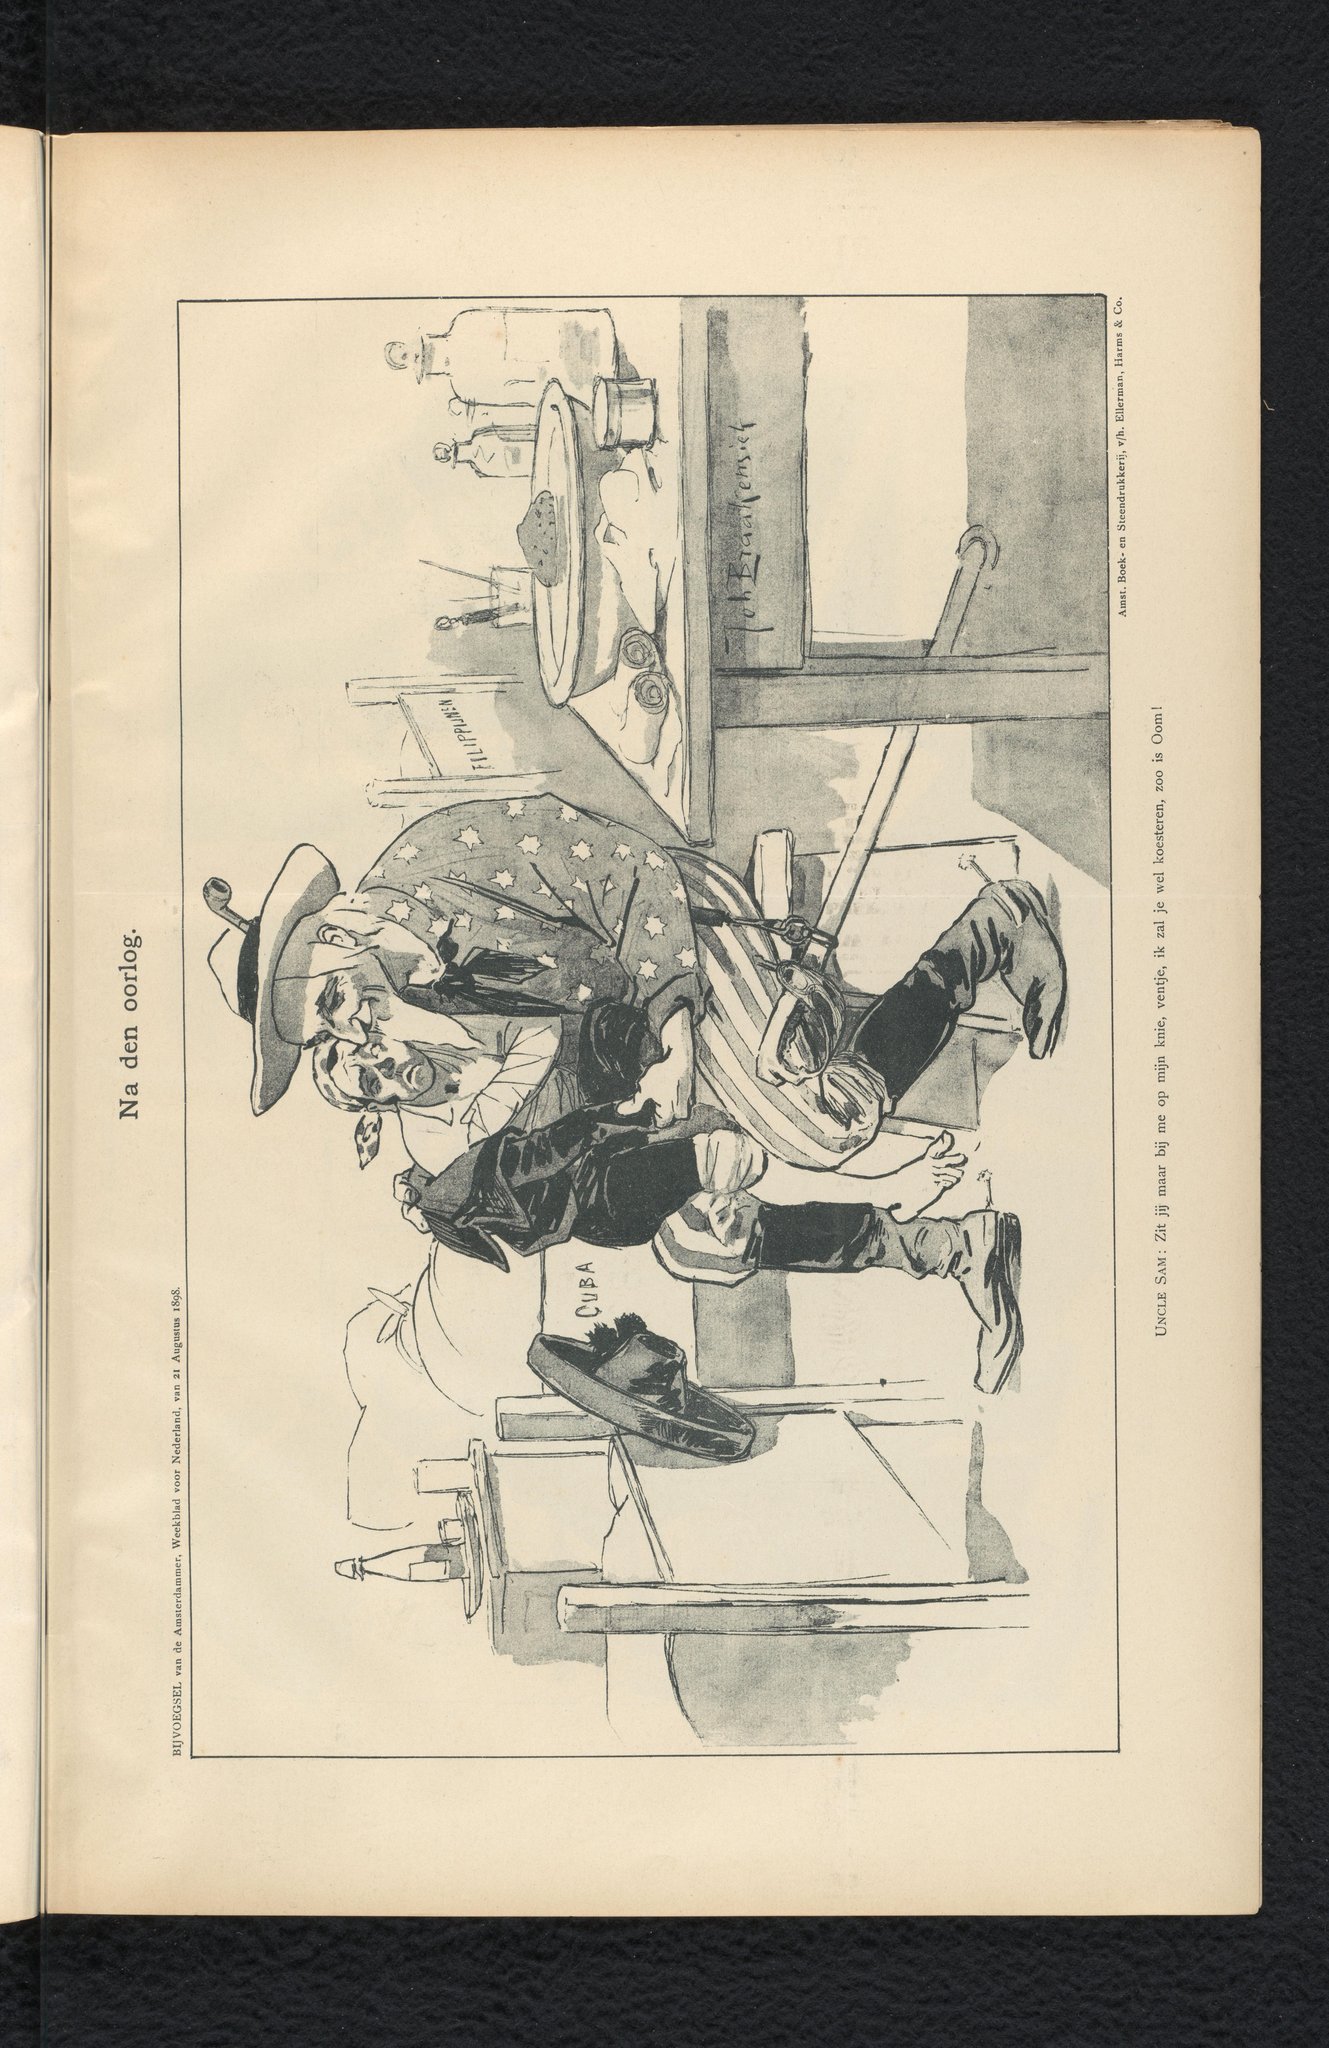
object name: cartoon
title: Na den oorlog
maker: johan braakensiek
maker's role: draughtsman, print maker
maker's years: 1858-1940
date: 1898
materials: paper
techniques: lithograph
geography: netherlands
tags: personifications of countries, nations, states, districts, etc., nursing, tending the sick, political caricatures and satires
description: Uncle Sam (Verenigde Staten) neemt het gewonde jongetje Cuba op de knie om hem te verzorgen. Verderop het bed van de Filipijnen. Na de Spaans-Amerikaanse oorlog.